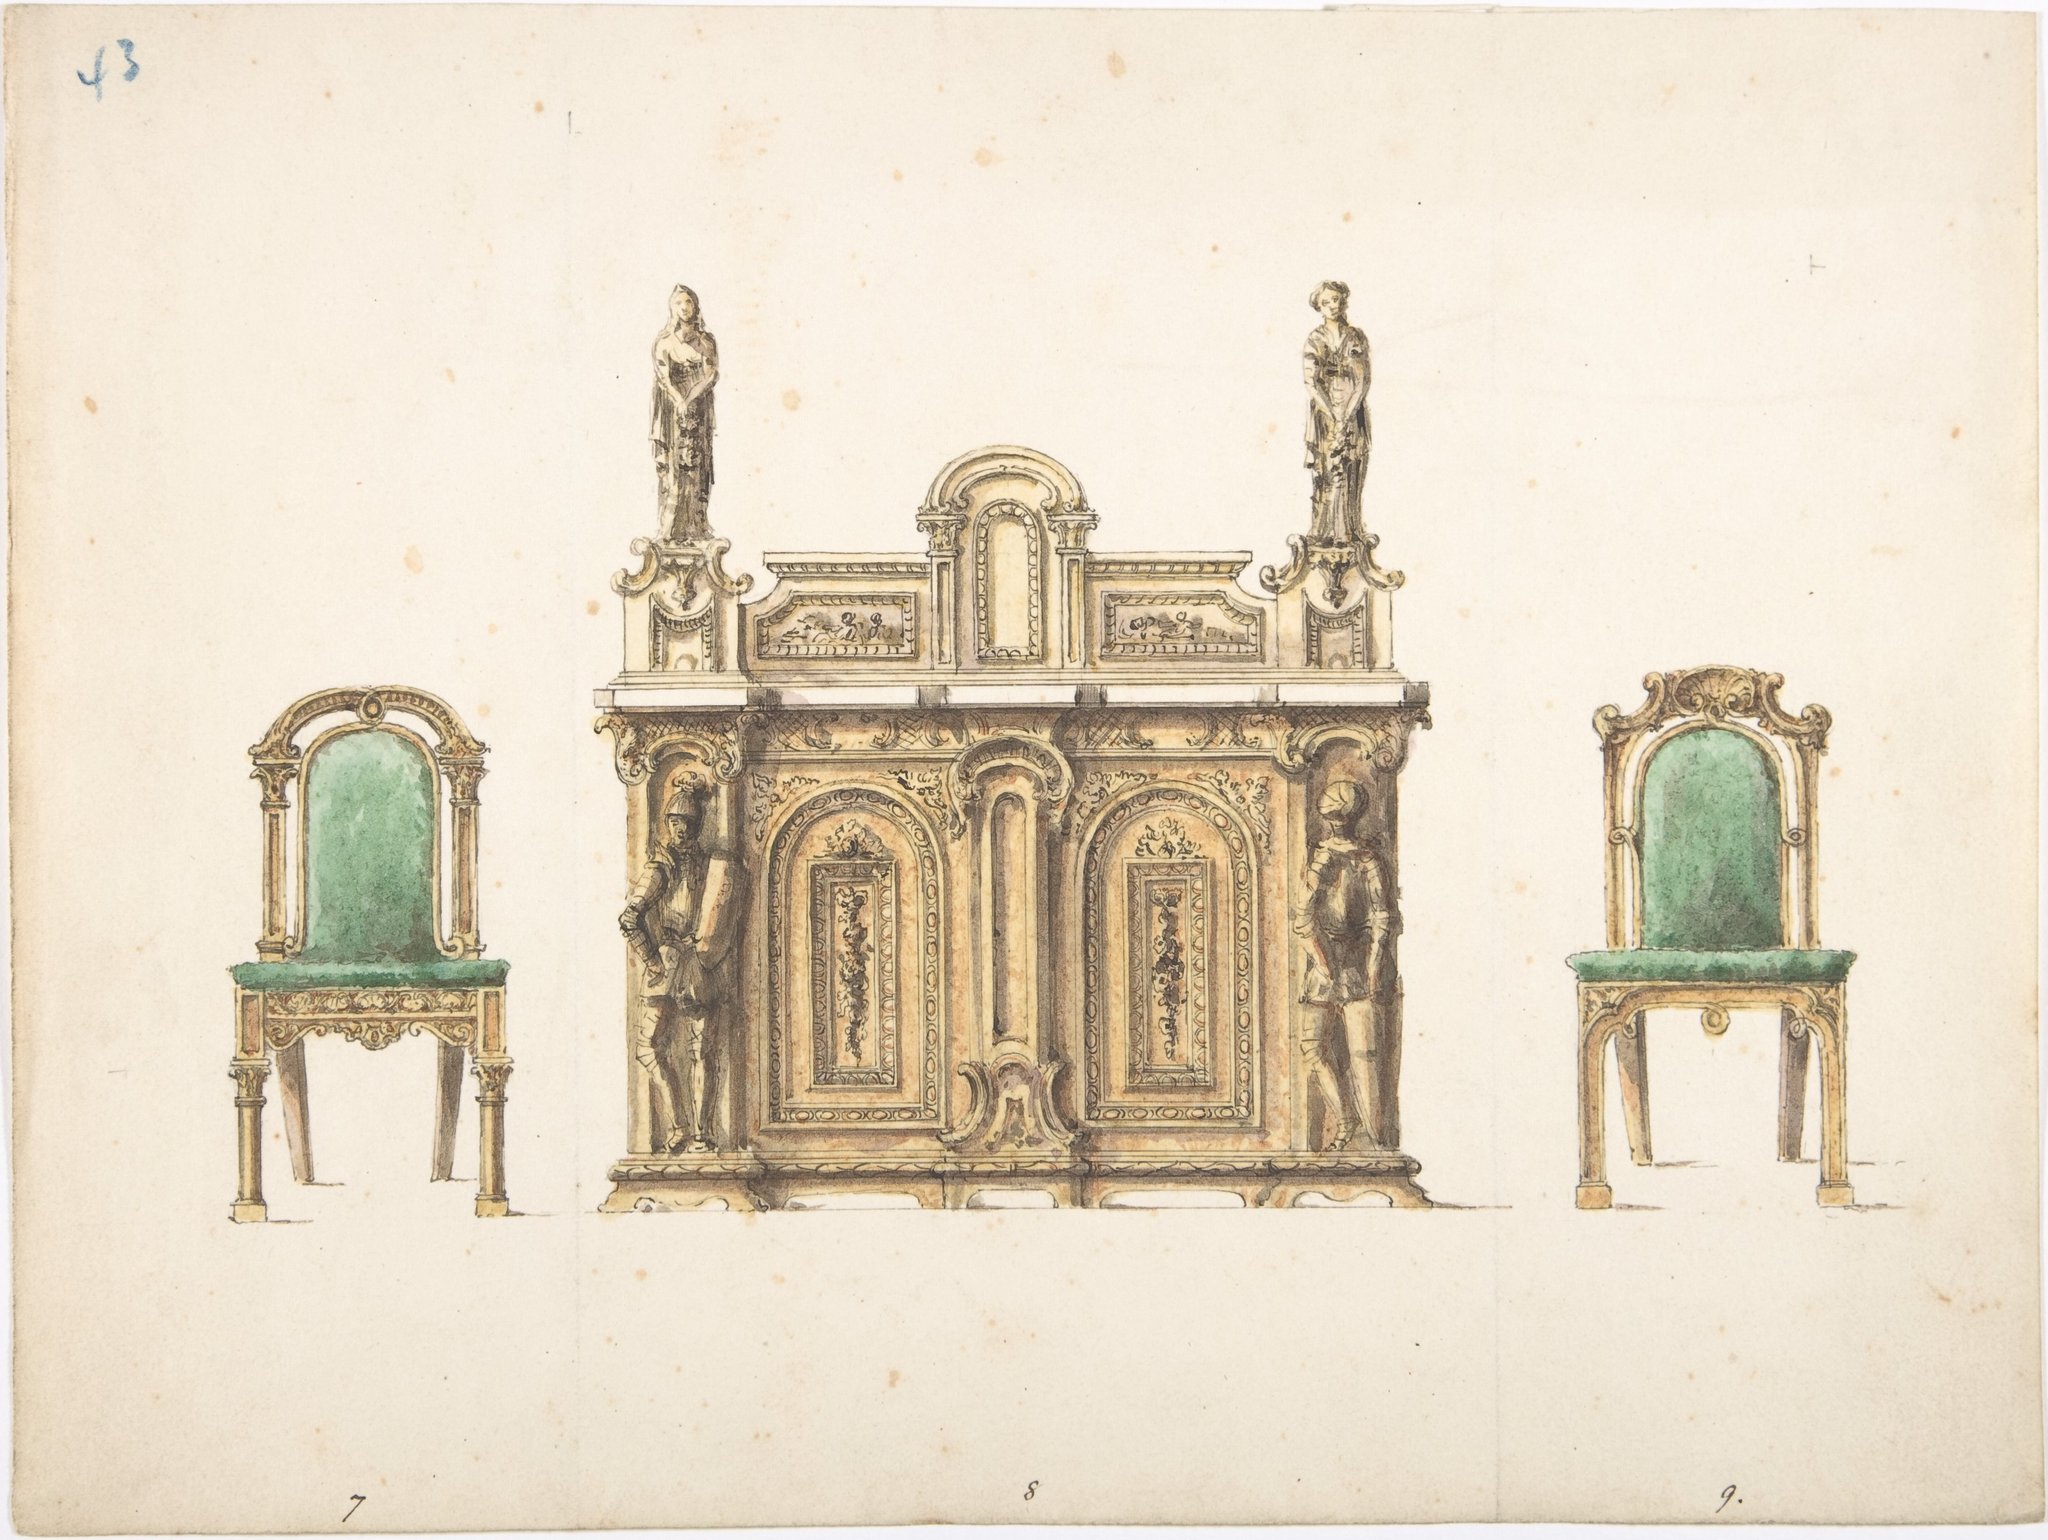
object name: drawing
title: Design for Cabinet Ornamented with Carved Knights and Ladies, and Two Chairs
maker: anonymous, british, 19th century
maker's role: artist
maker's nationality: british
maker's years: 1800-1900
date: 1801-1833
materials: ink, watercolor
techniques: brush, pen, wash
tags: men,women,cabinets